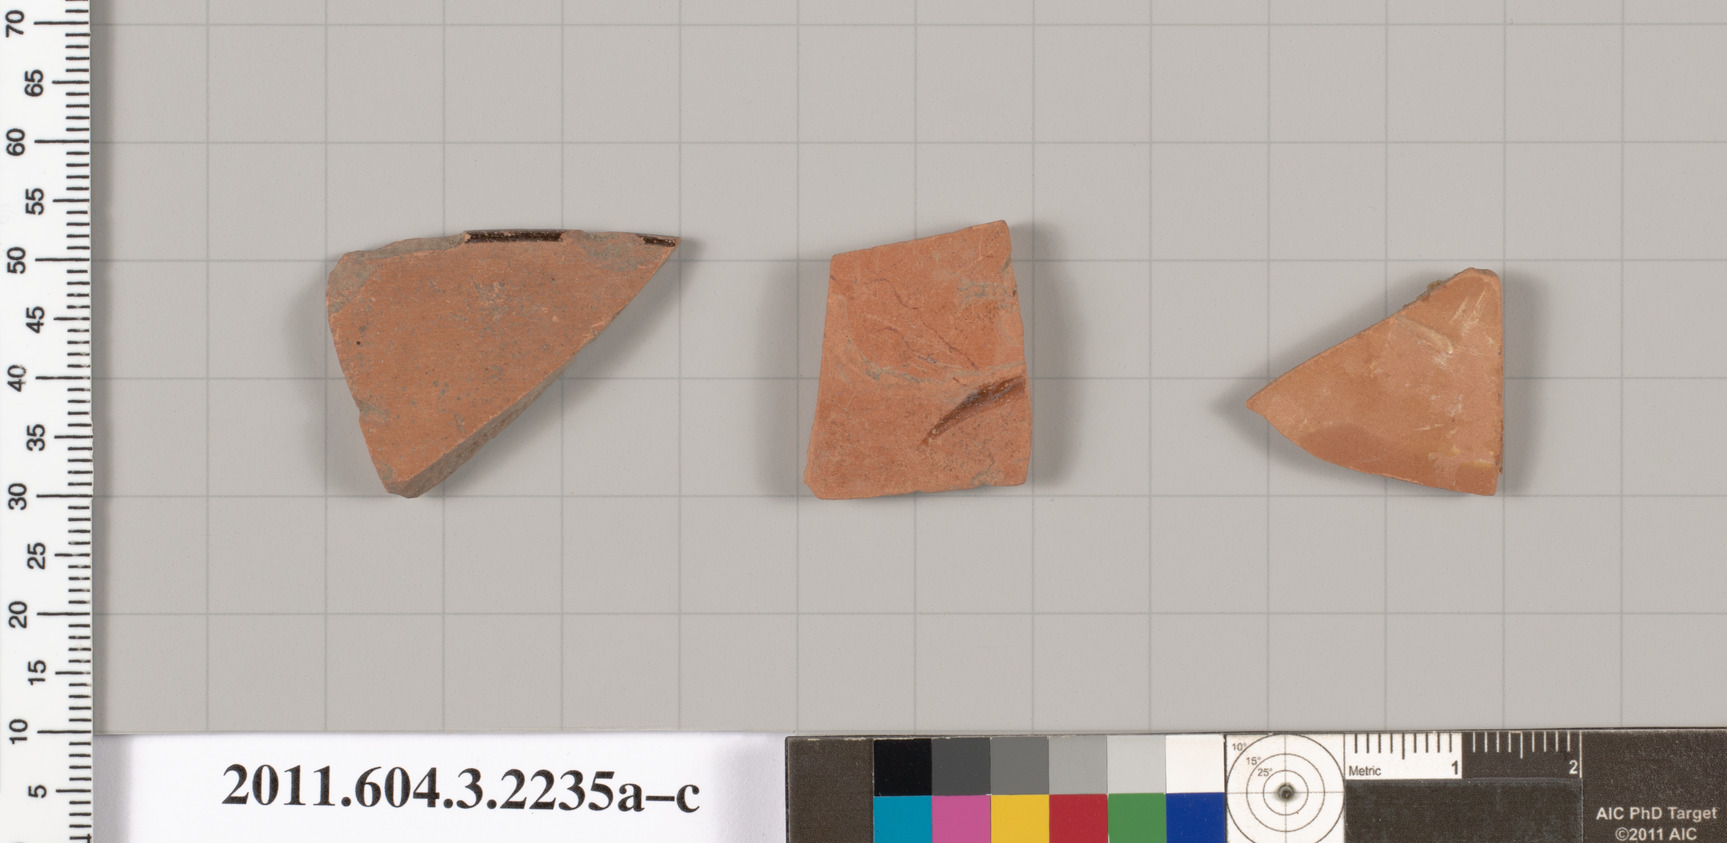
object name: kylix fragment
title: Terracotta fragments of kylikes (drinking cups)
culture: greek, attic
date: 600-401 BCE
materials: terracotta